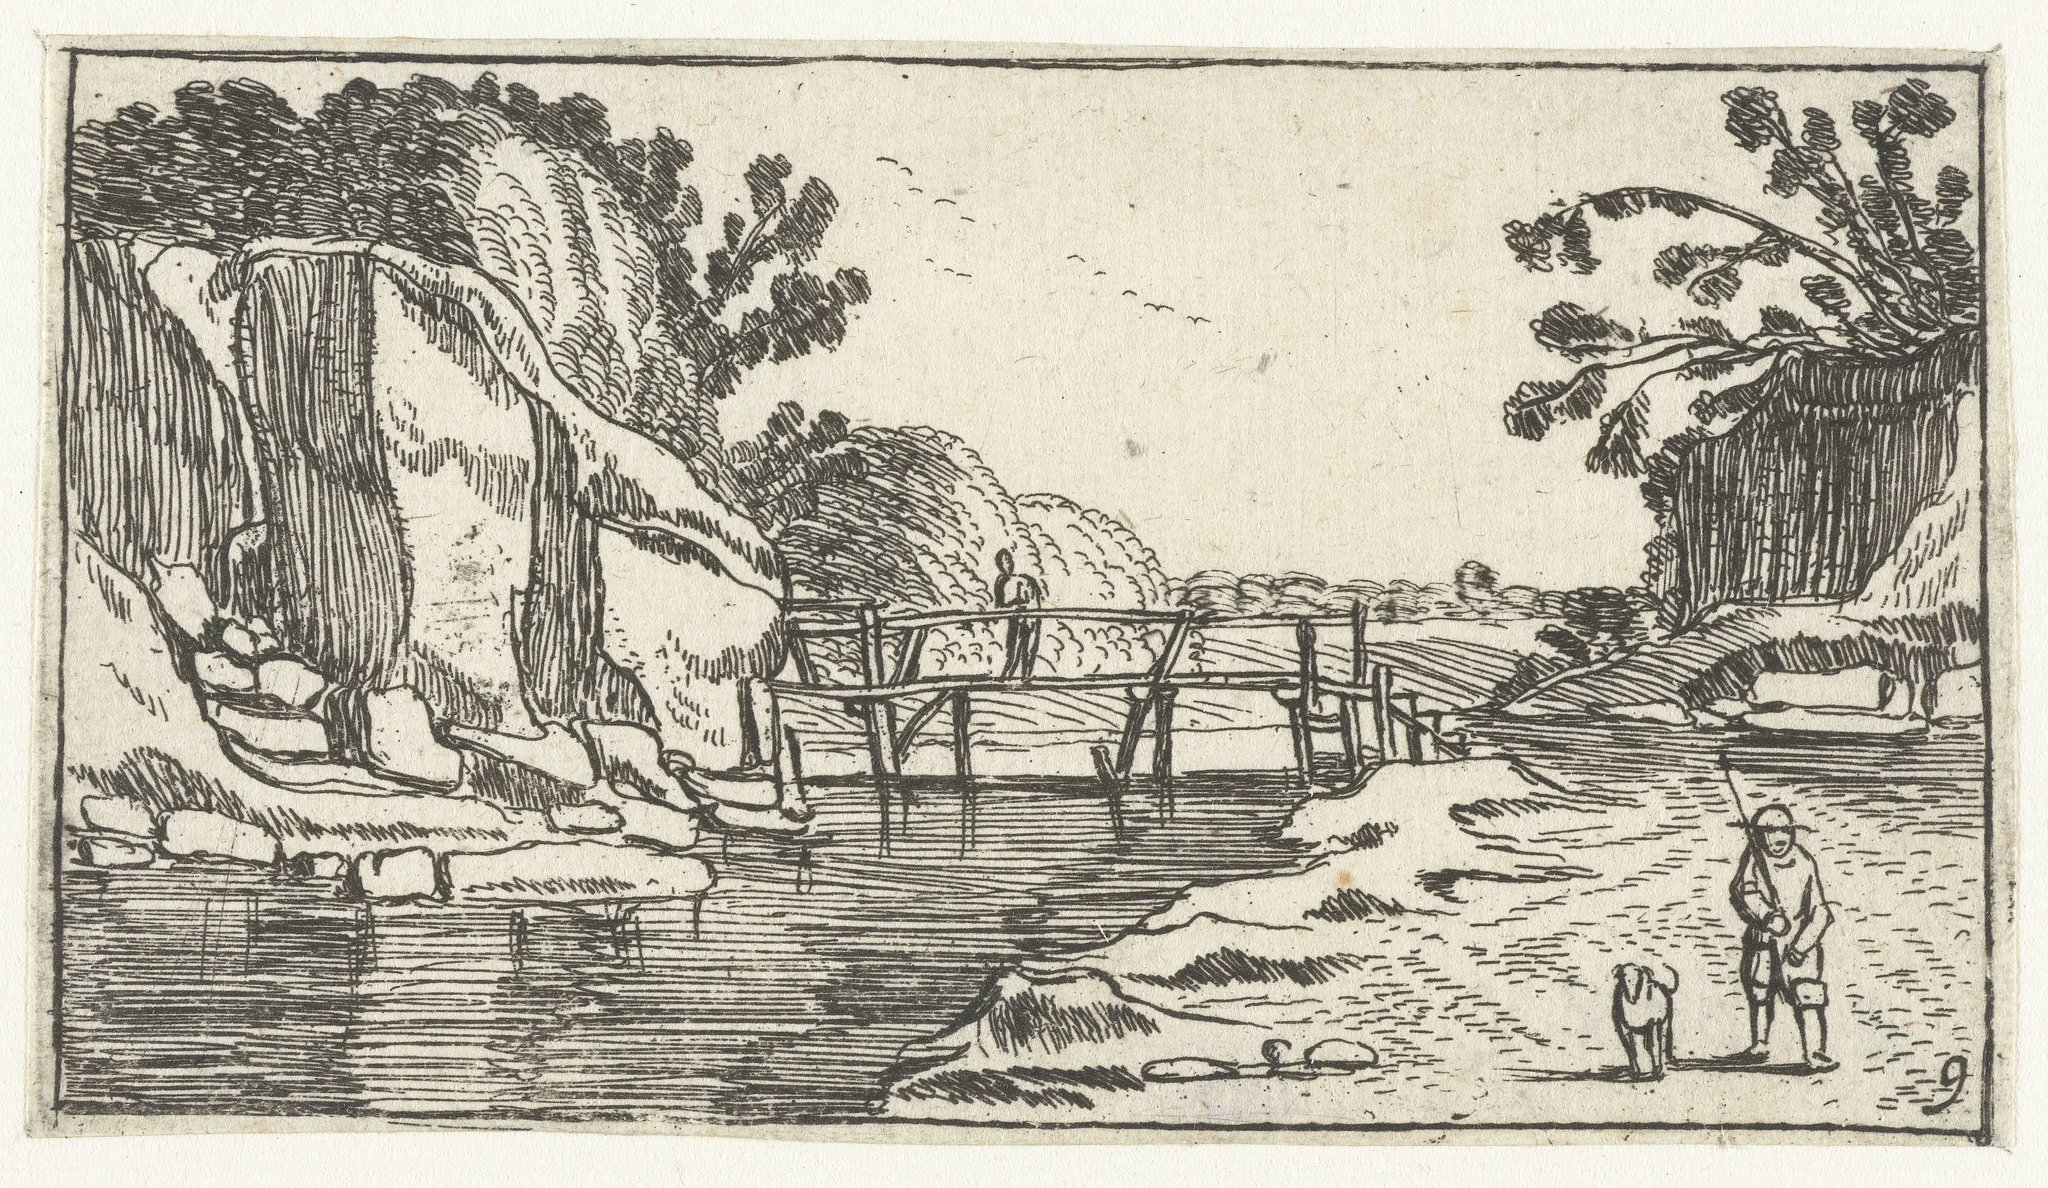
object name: print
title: Landschappen naar Esaias van de Velde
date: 1610-1617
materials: paper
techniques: etching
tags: landscape with bridge, viaduct or aqueduct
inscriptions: collector's mark: Lugt 2227